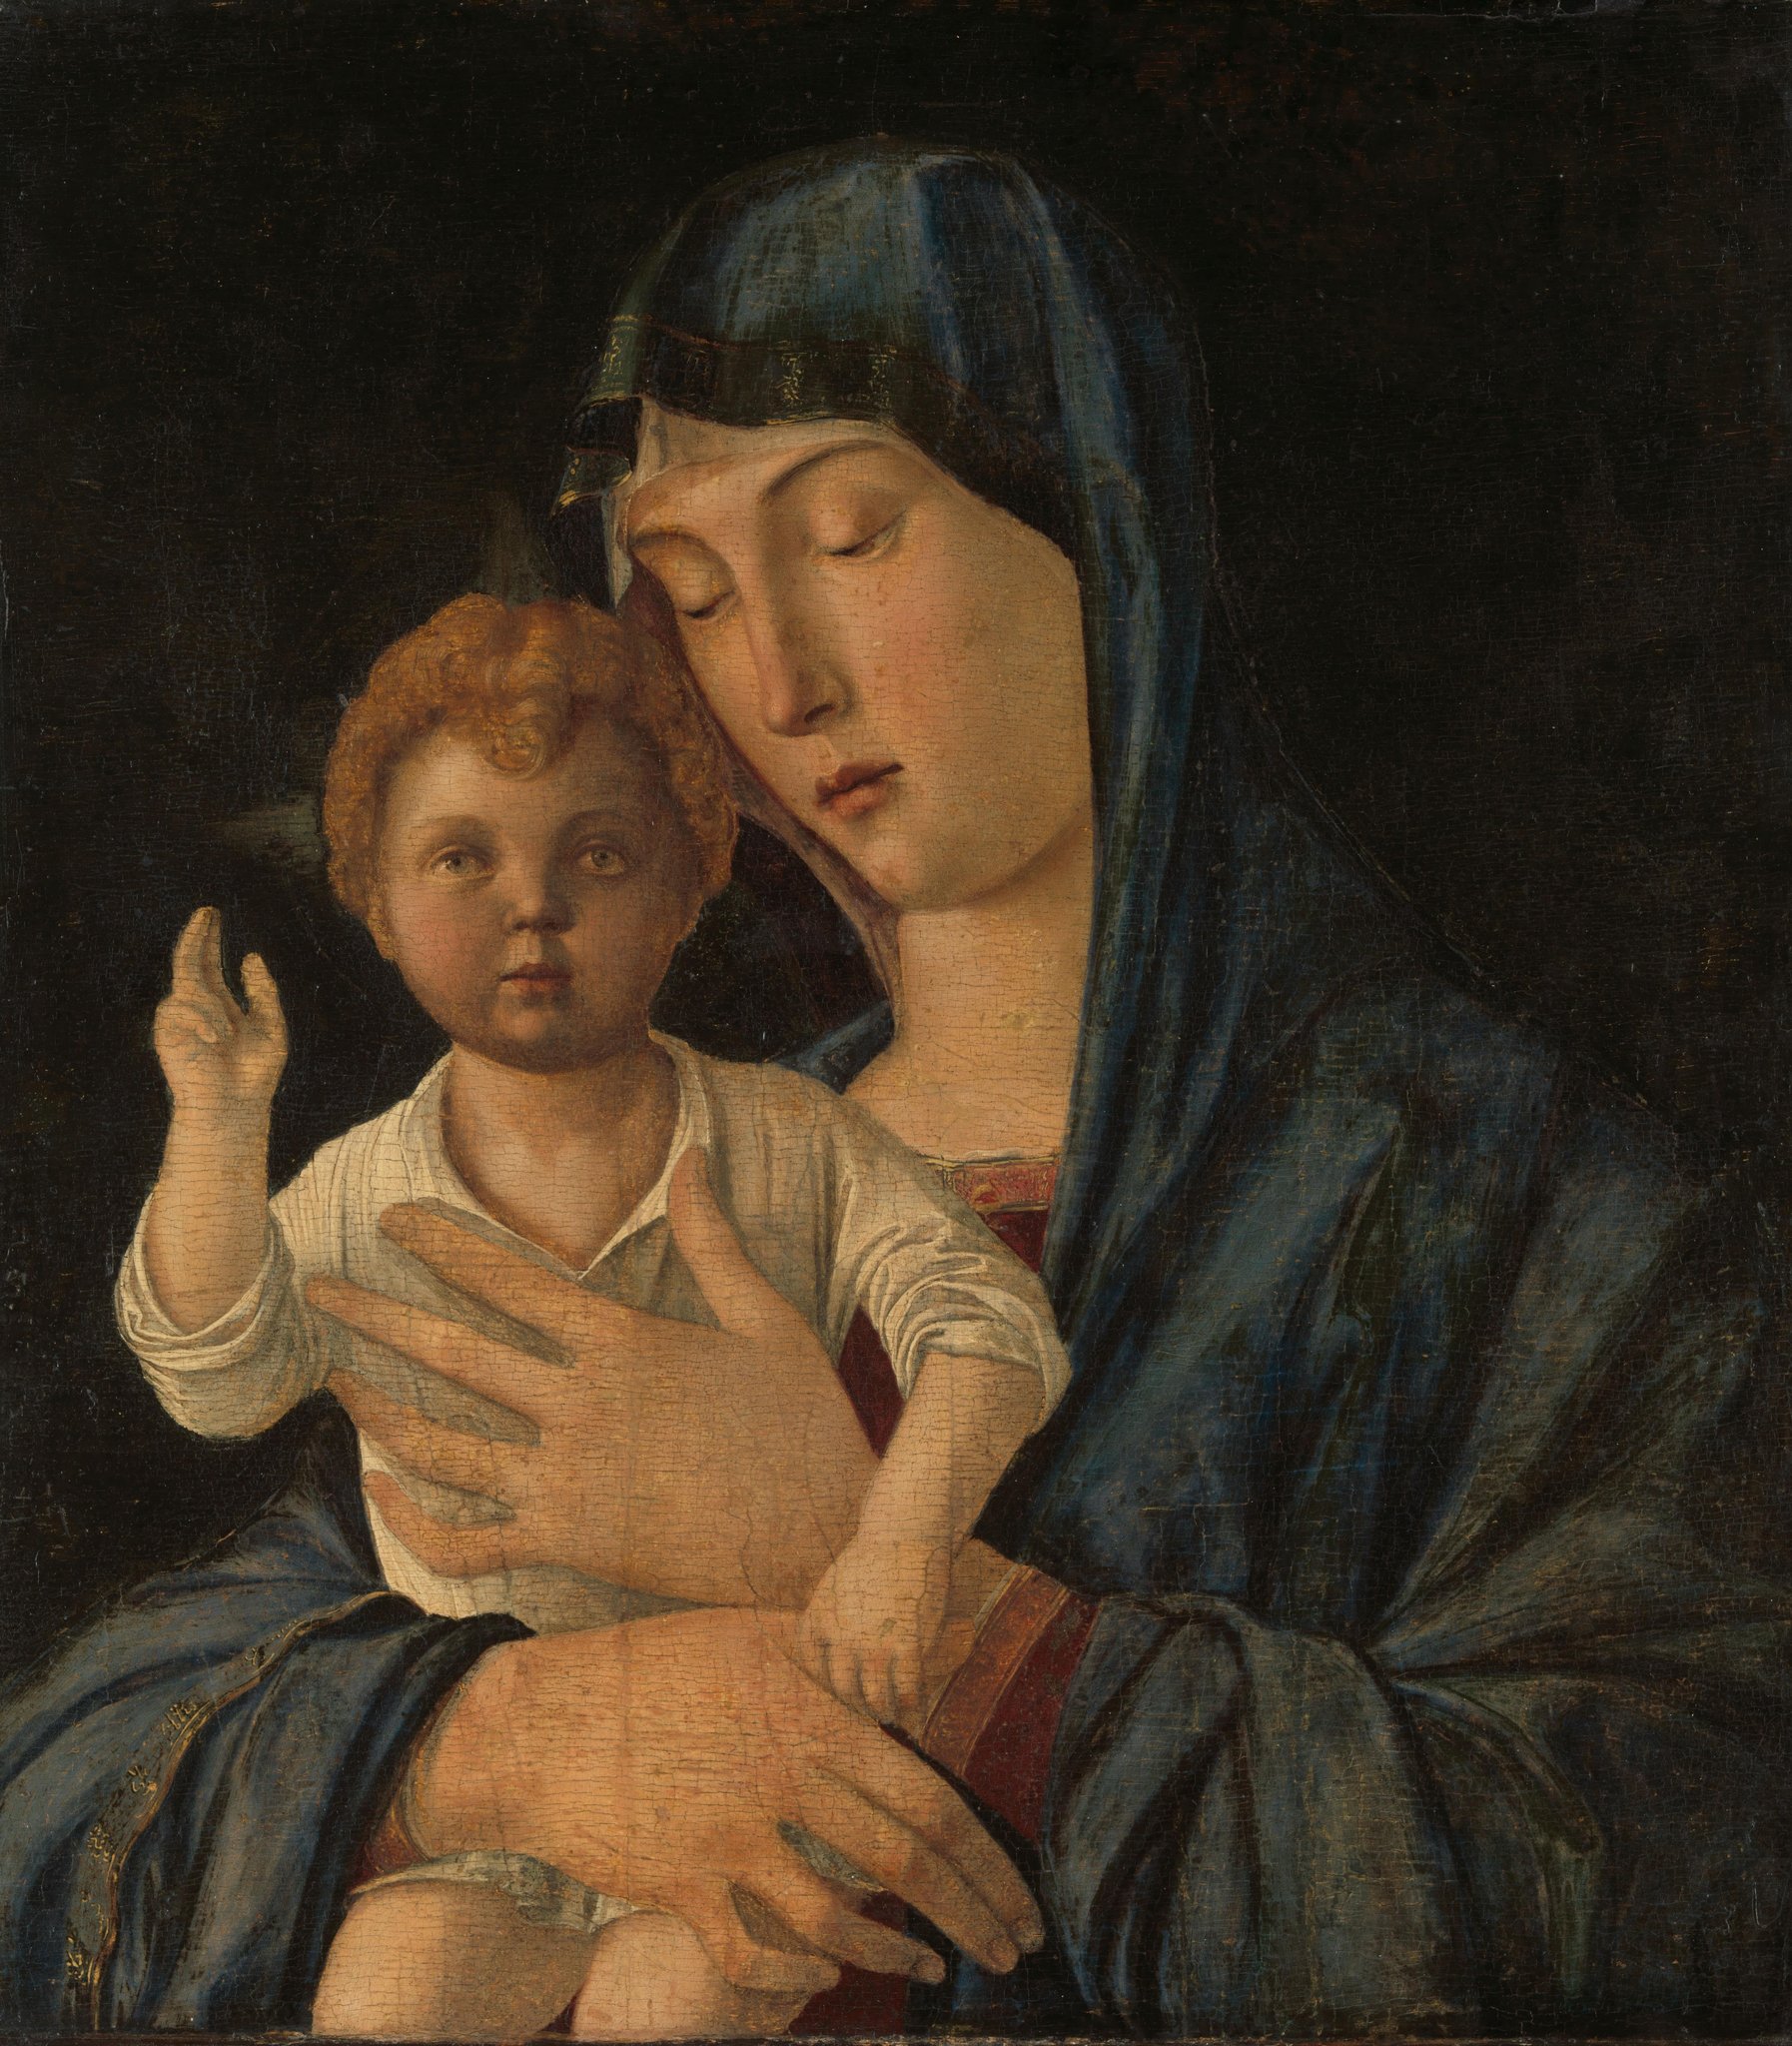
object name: painting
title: Madonna and Child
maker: giovanni bellini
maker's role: draughtsman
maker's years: 1430-1516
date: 1470-1480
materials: oil, panel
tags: madonna: i.e. mary with the christ-child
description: Madonna met kind. Maria met het zegenende Christuskind staande op haar schoot.